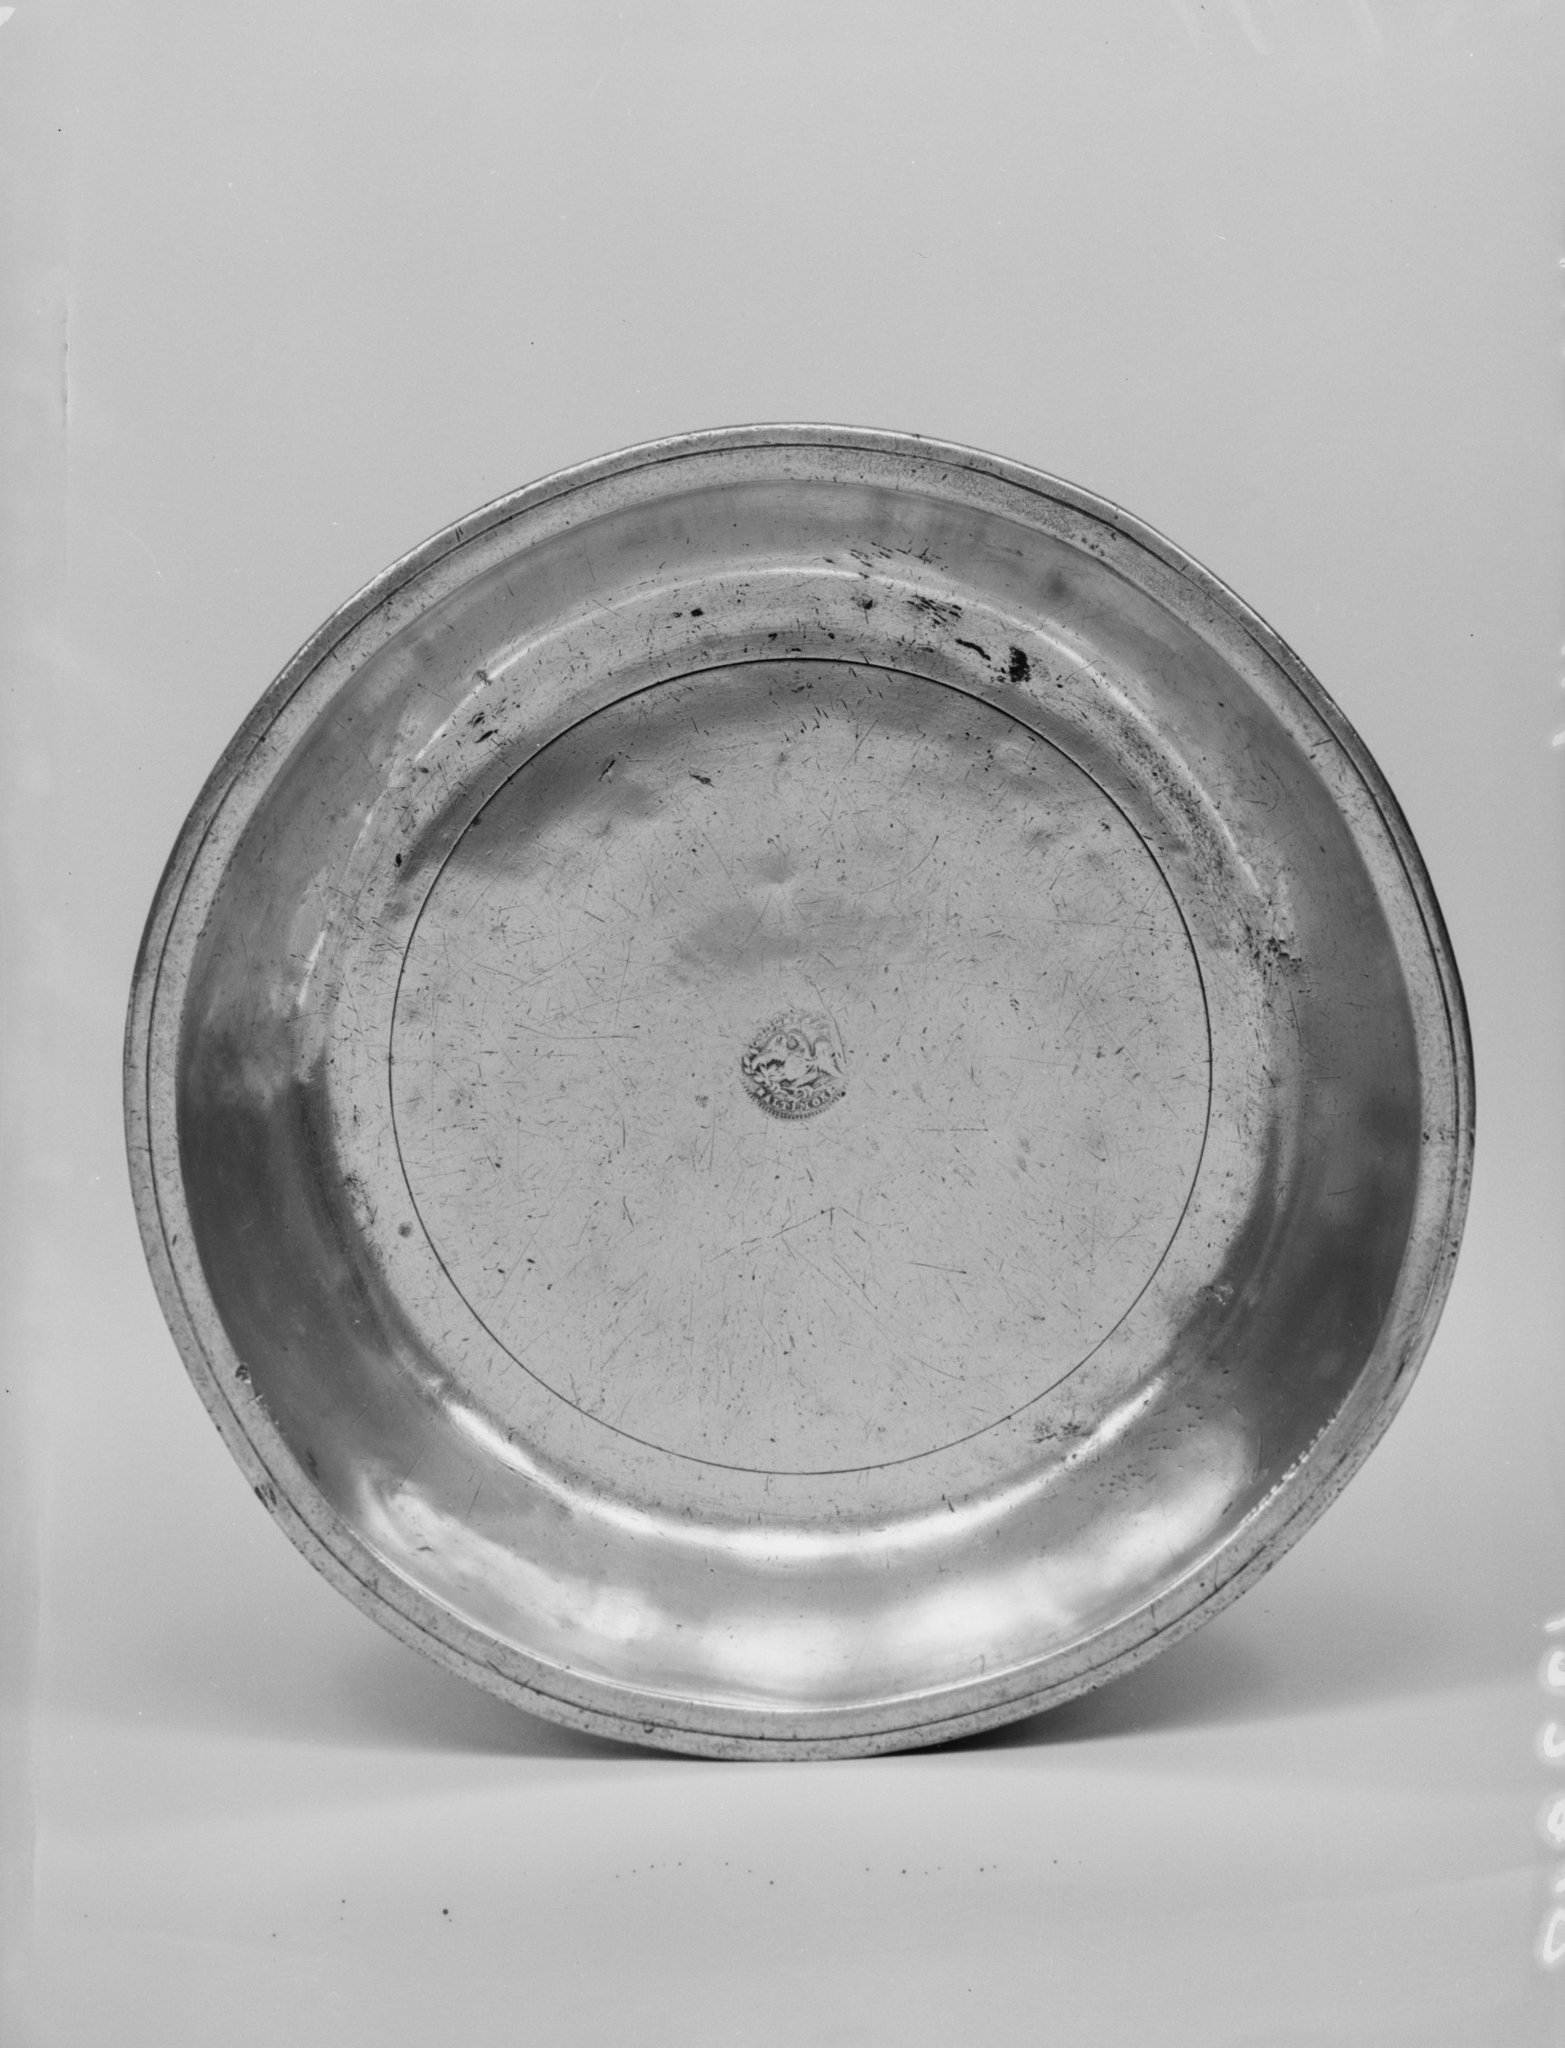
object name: basin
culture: american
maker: george lightner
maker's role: maker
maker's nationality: american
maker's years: 1749-1815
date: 1806-1815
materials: pewter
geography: united states